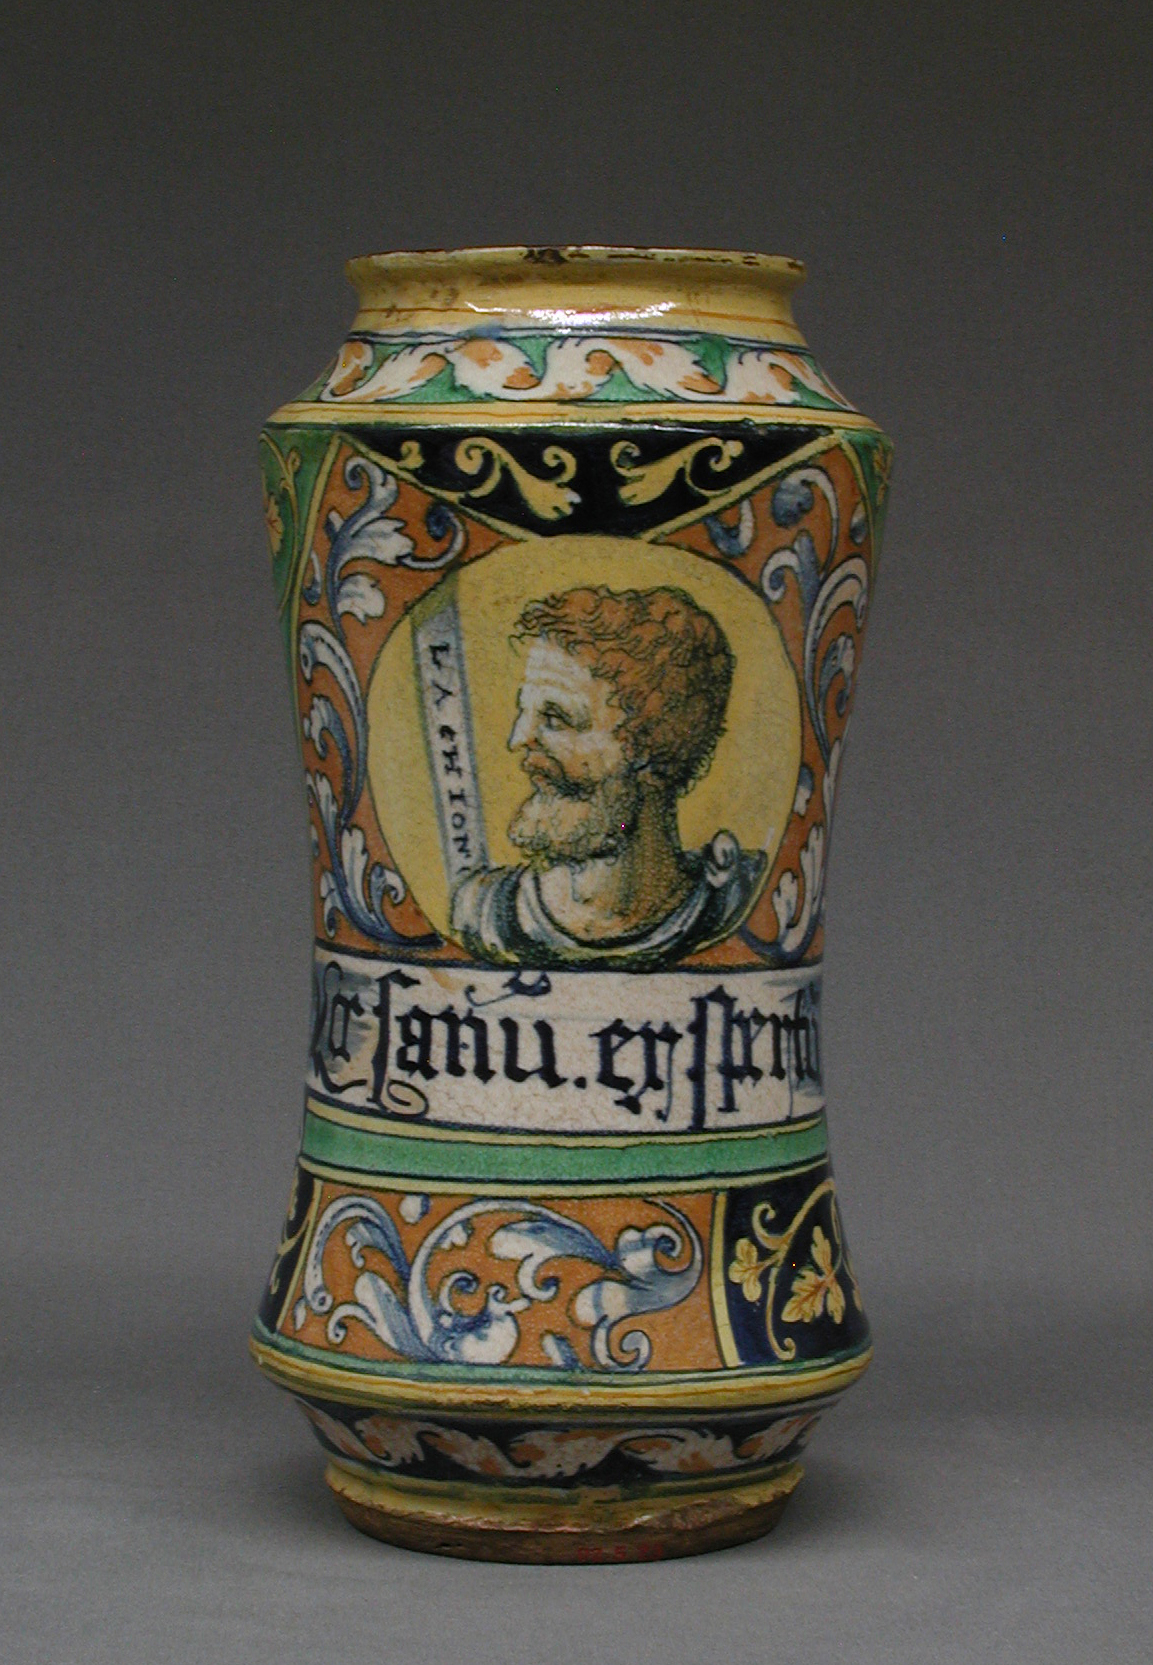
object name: albarello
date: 1534-1566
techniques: maiolica, glazing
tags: men,profiles,flowers